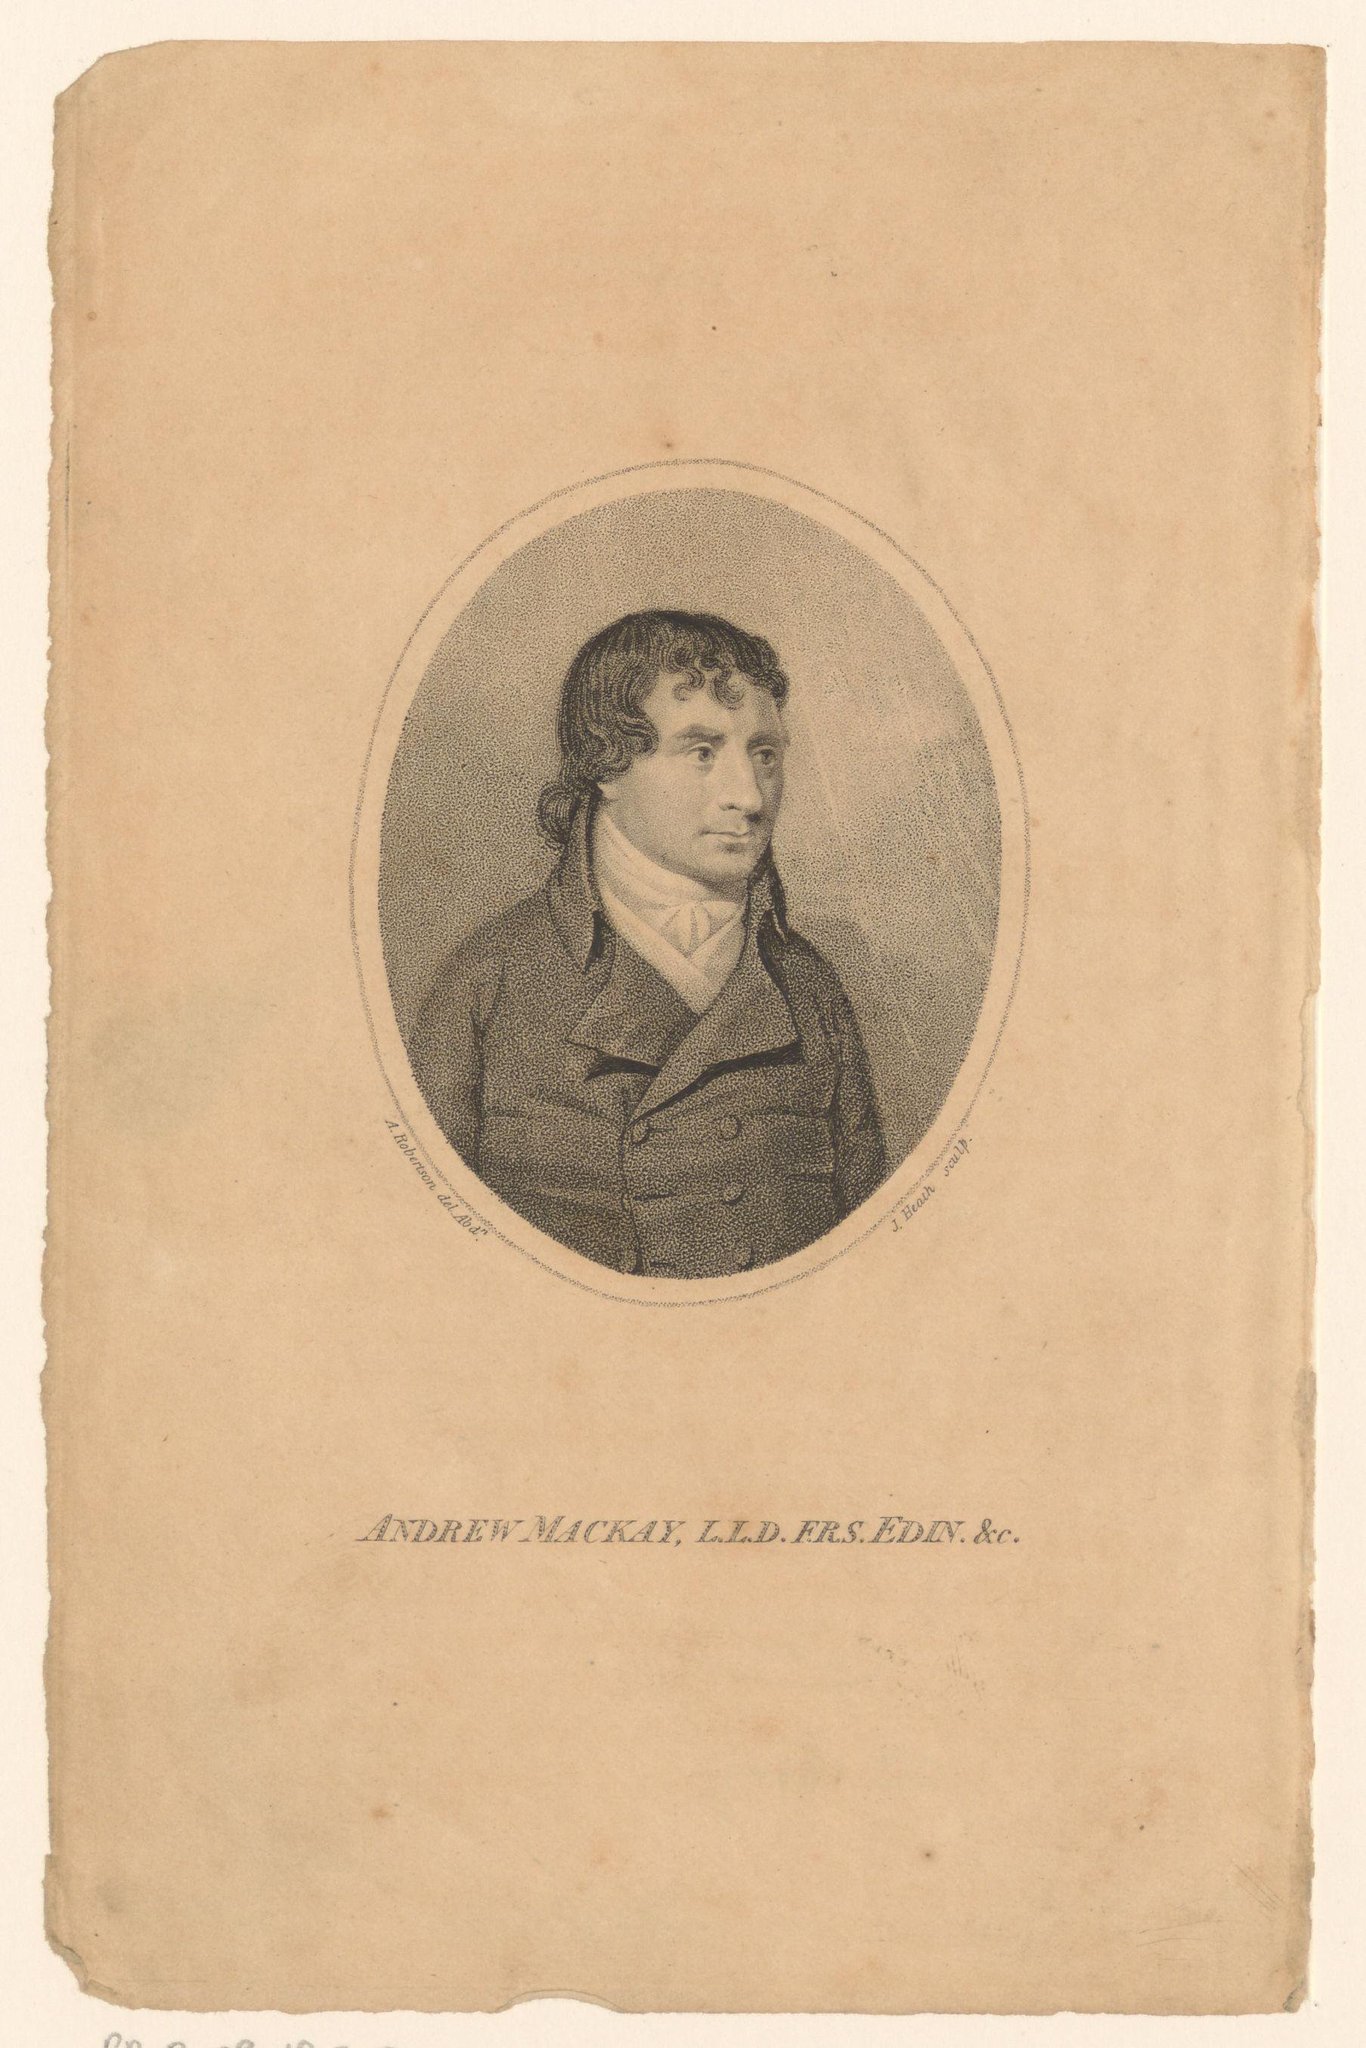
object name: book illustration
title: Portret van Andrew Mackay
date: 1812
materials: paper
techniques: etching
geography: leith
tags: historical persons, mathematics (+ portrait of scholar, scientist)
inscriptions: collector's mark: Lugt 2228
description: Prent uit: Mackay, Andrew. The Description and Use of the Sliding Gunter in Navigation. Leith: Archibald Allardice et al, 1812.